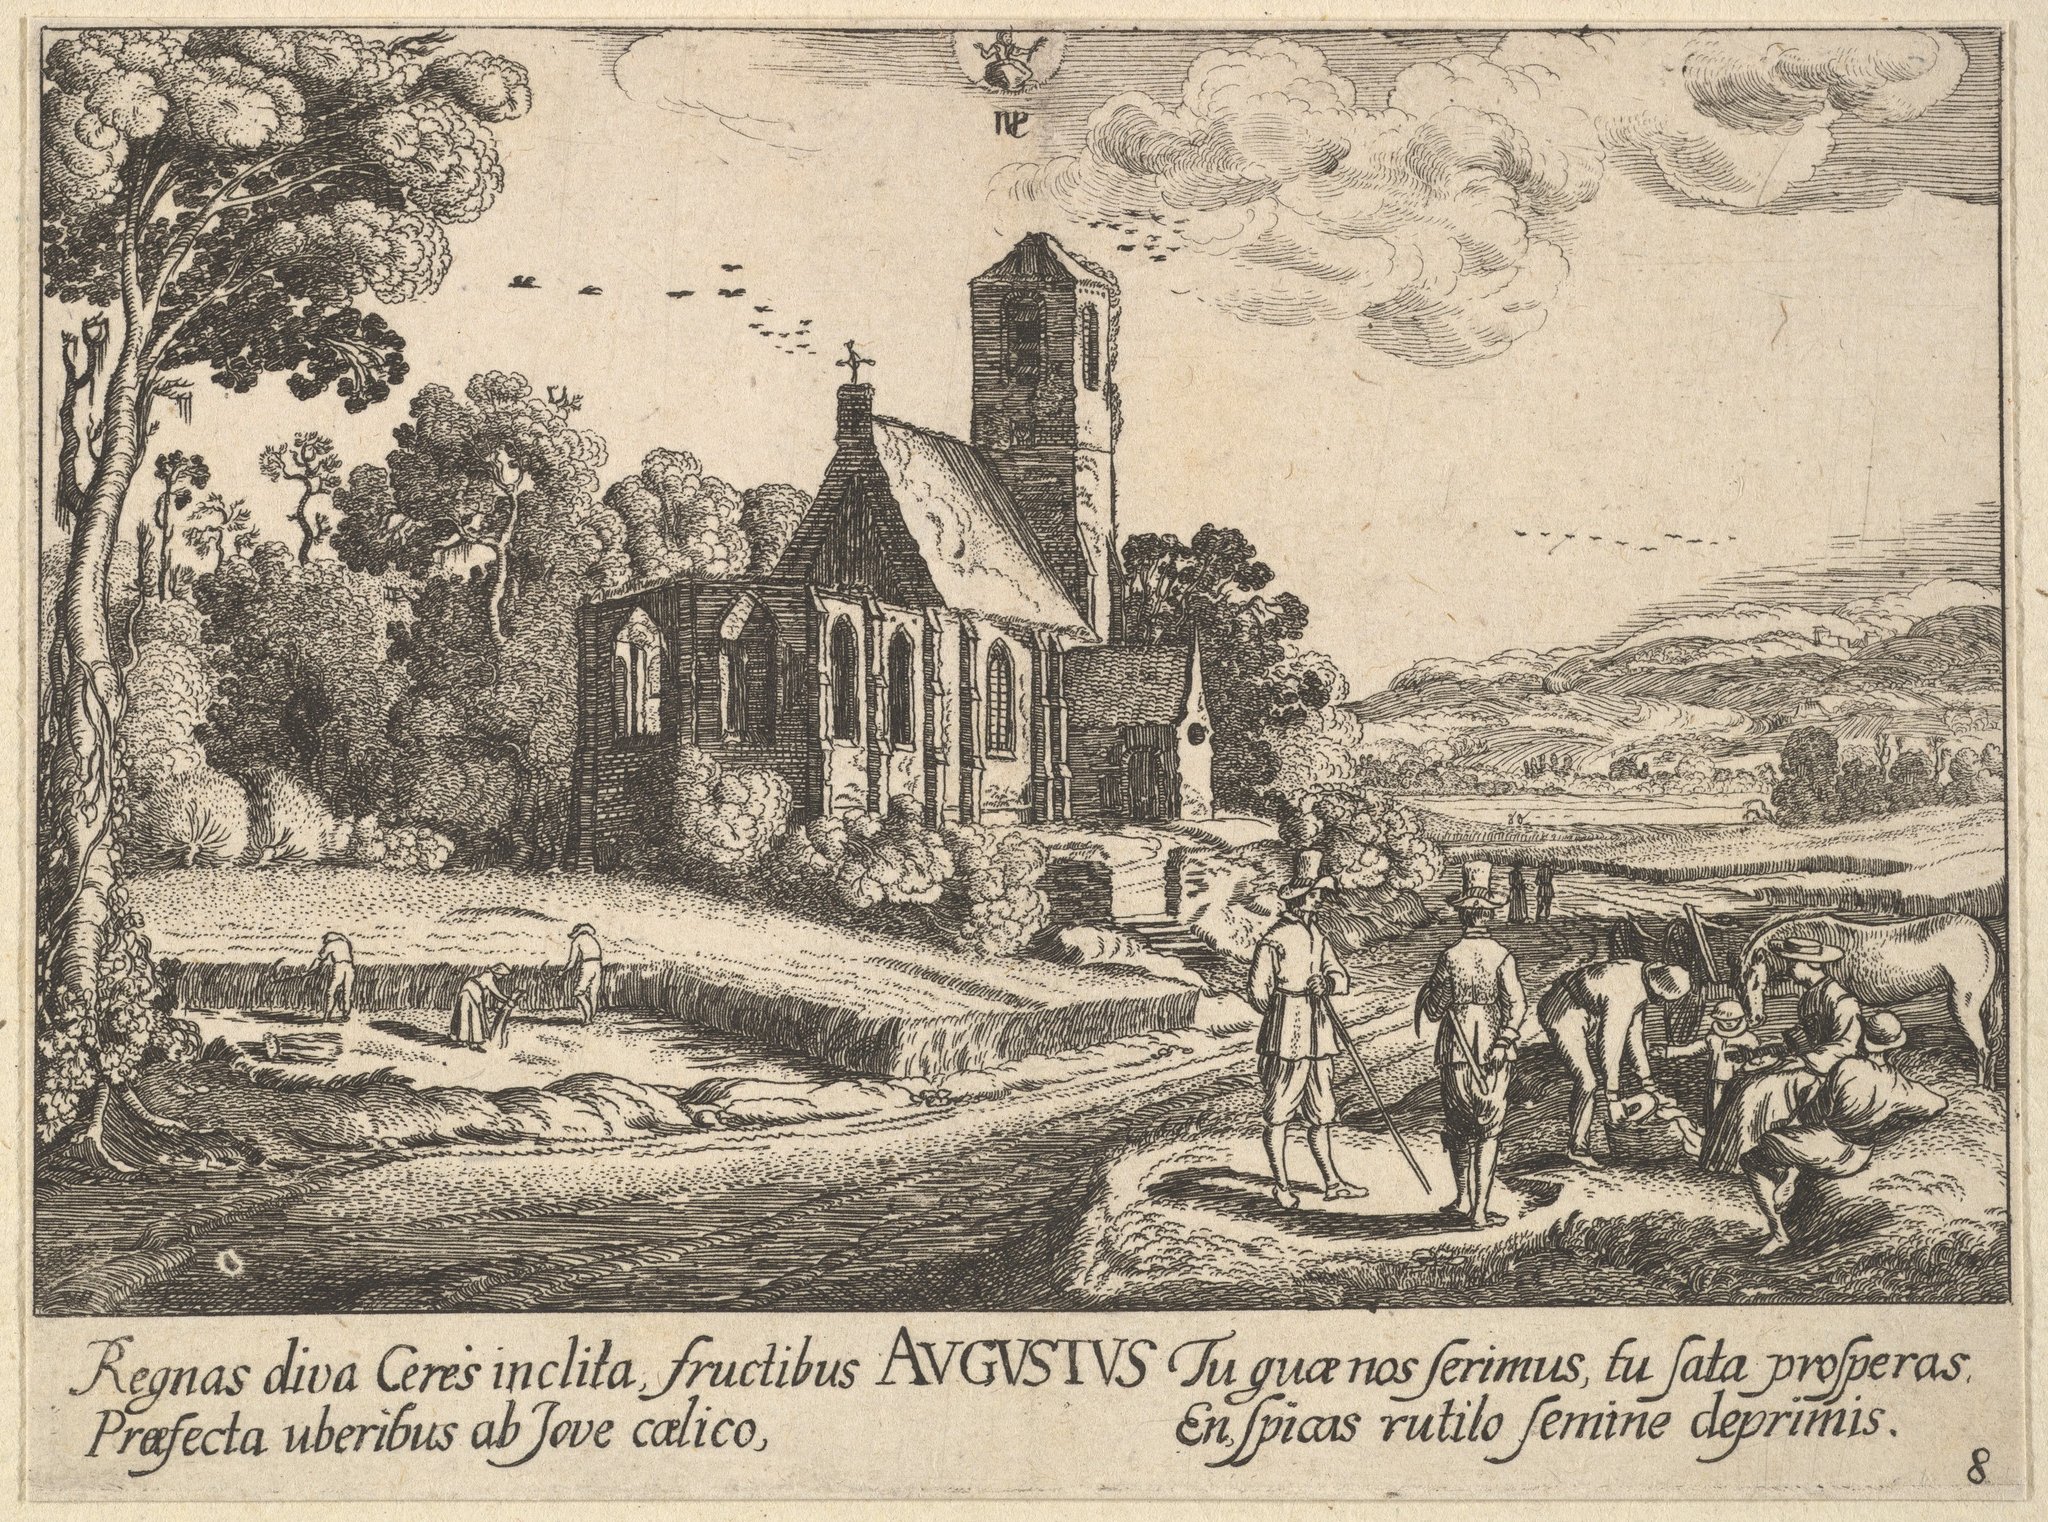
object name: print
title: August (Augustus)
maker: wenceslaus hollar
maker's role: artist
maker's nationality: bohemian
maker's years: 1607-1677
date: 1628-1629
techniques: etching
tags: churches,men,horses,trees